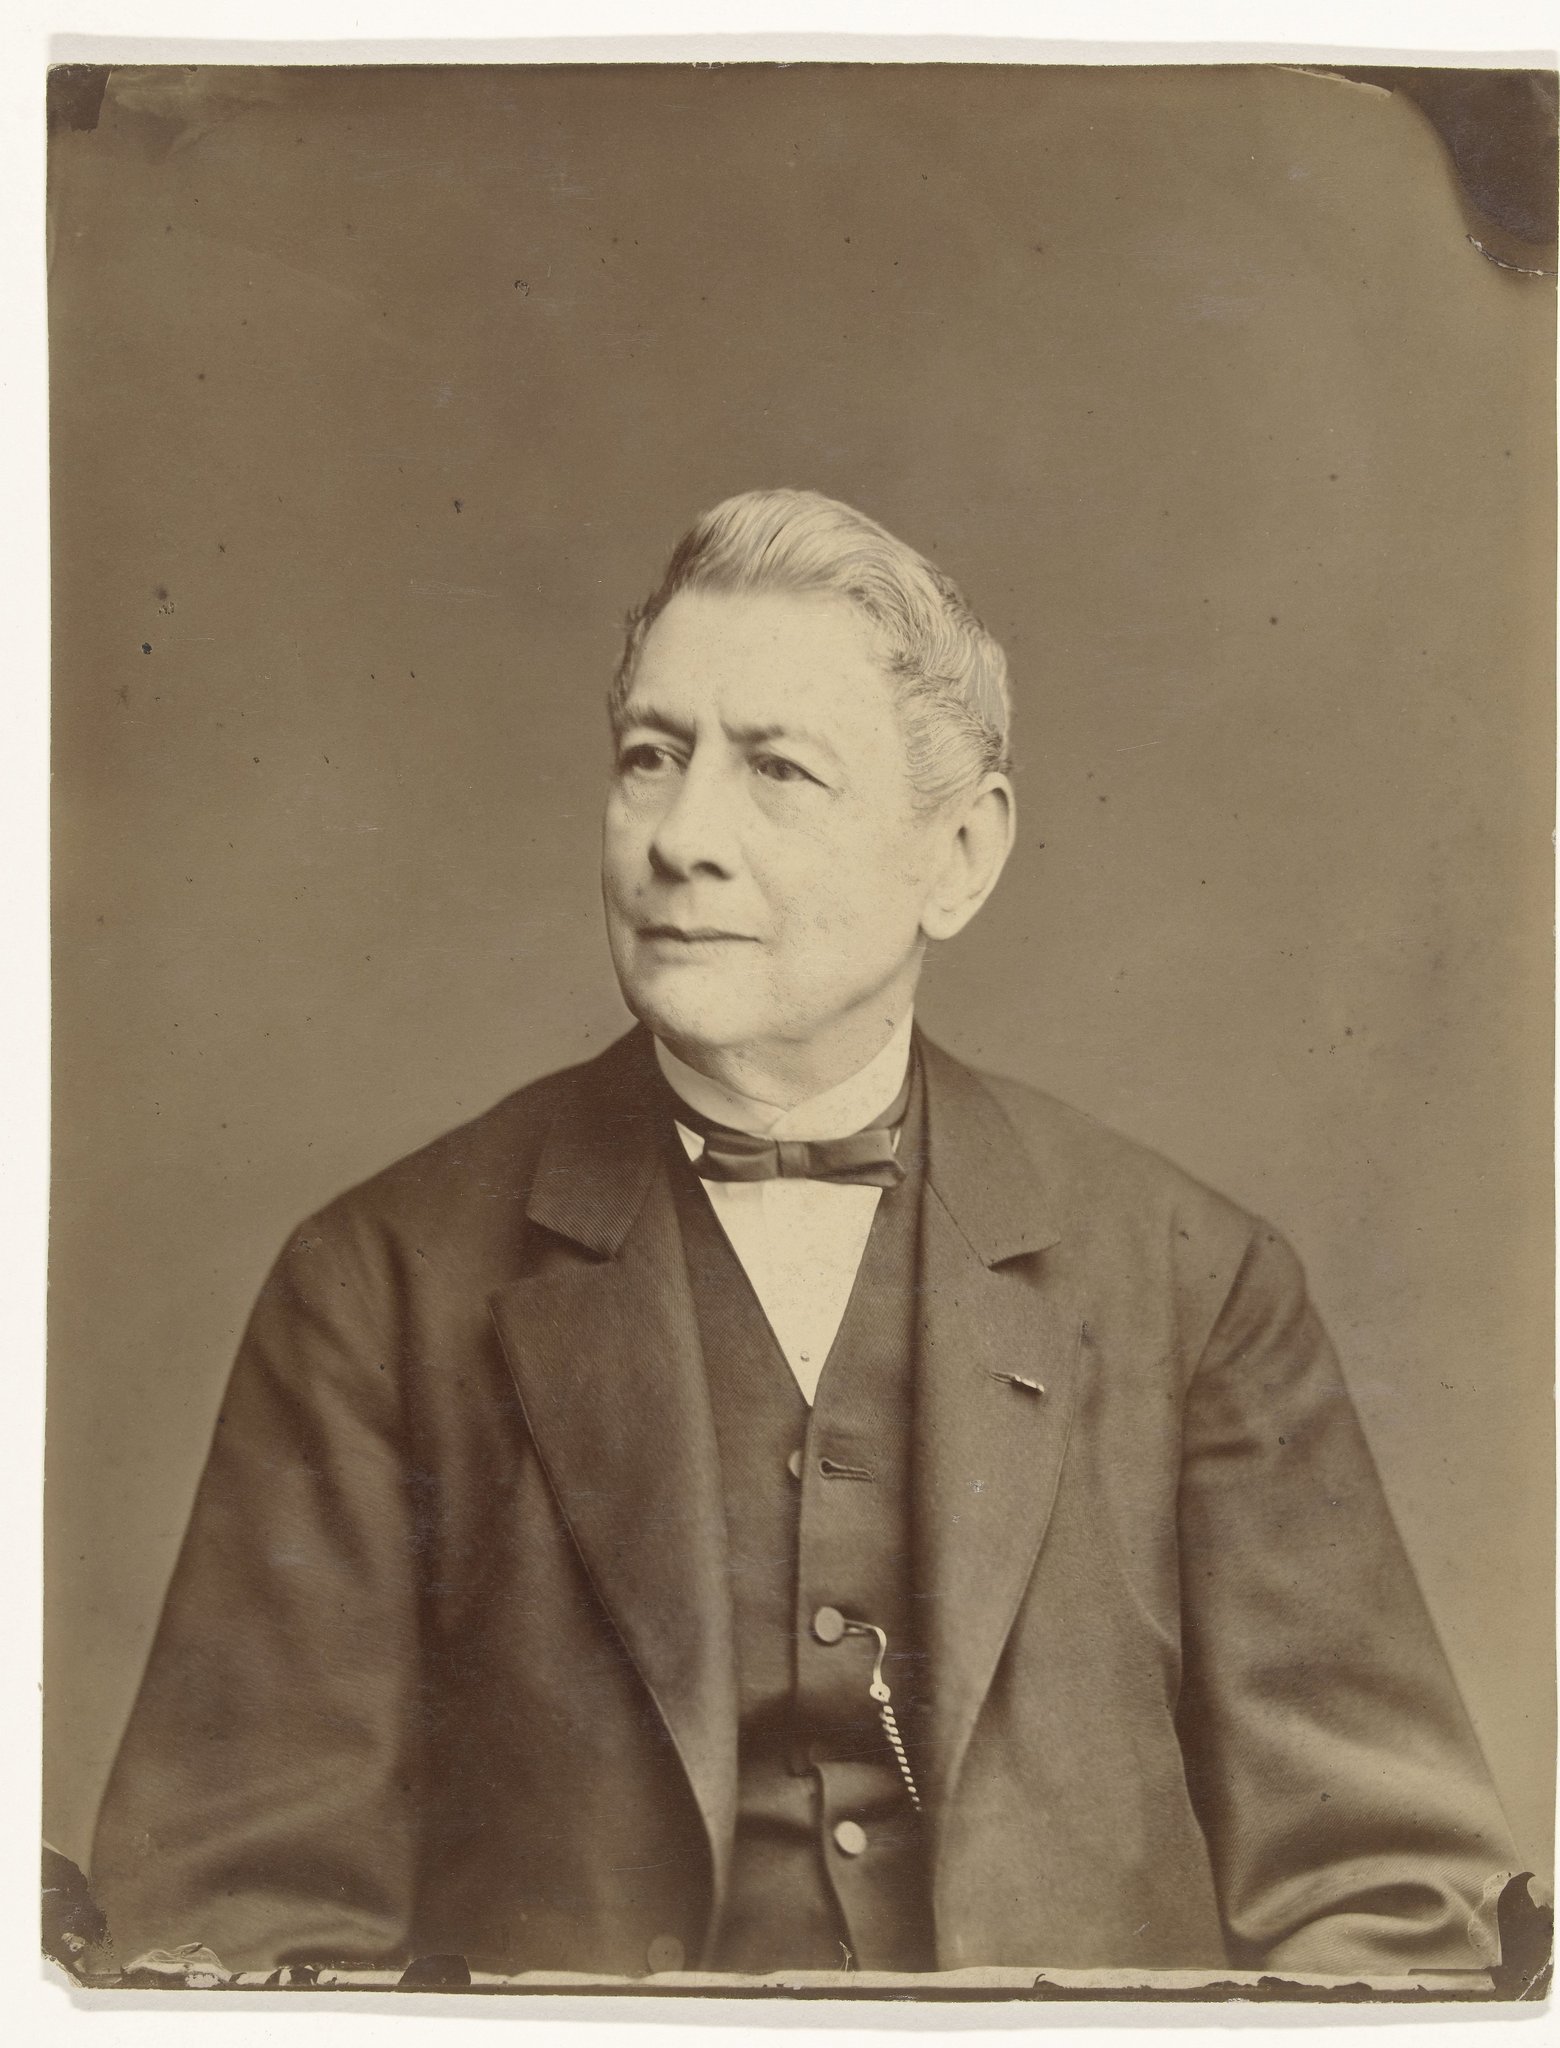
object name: photograph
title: Portret van J.J. van Braam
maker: Anonymous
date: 1875-1890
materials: paper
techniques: albumen print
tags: historical persons (portraits and scenes from the life)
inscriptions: annotation: ‘Van Braam’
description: vgl 2 vroege portretten van Van Braam en zijn vrouw bij KITLV en fotocollectie Rijksmuseum